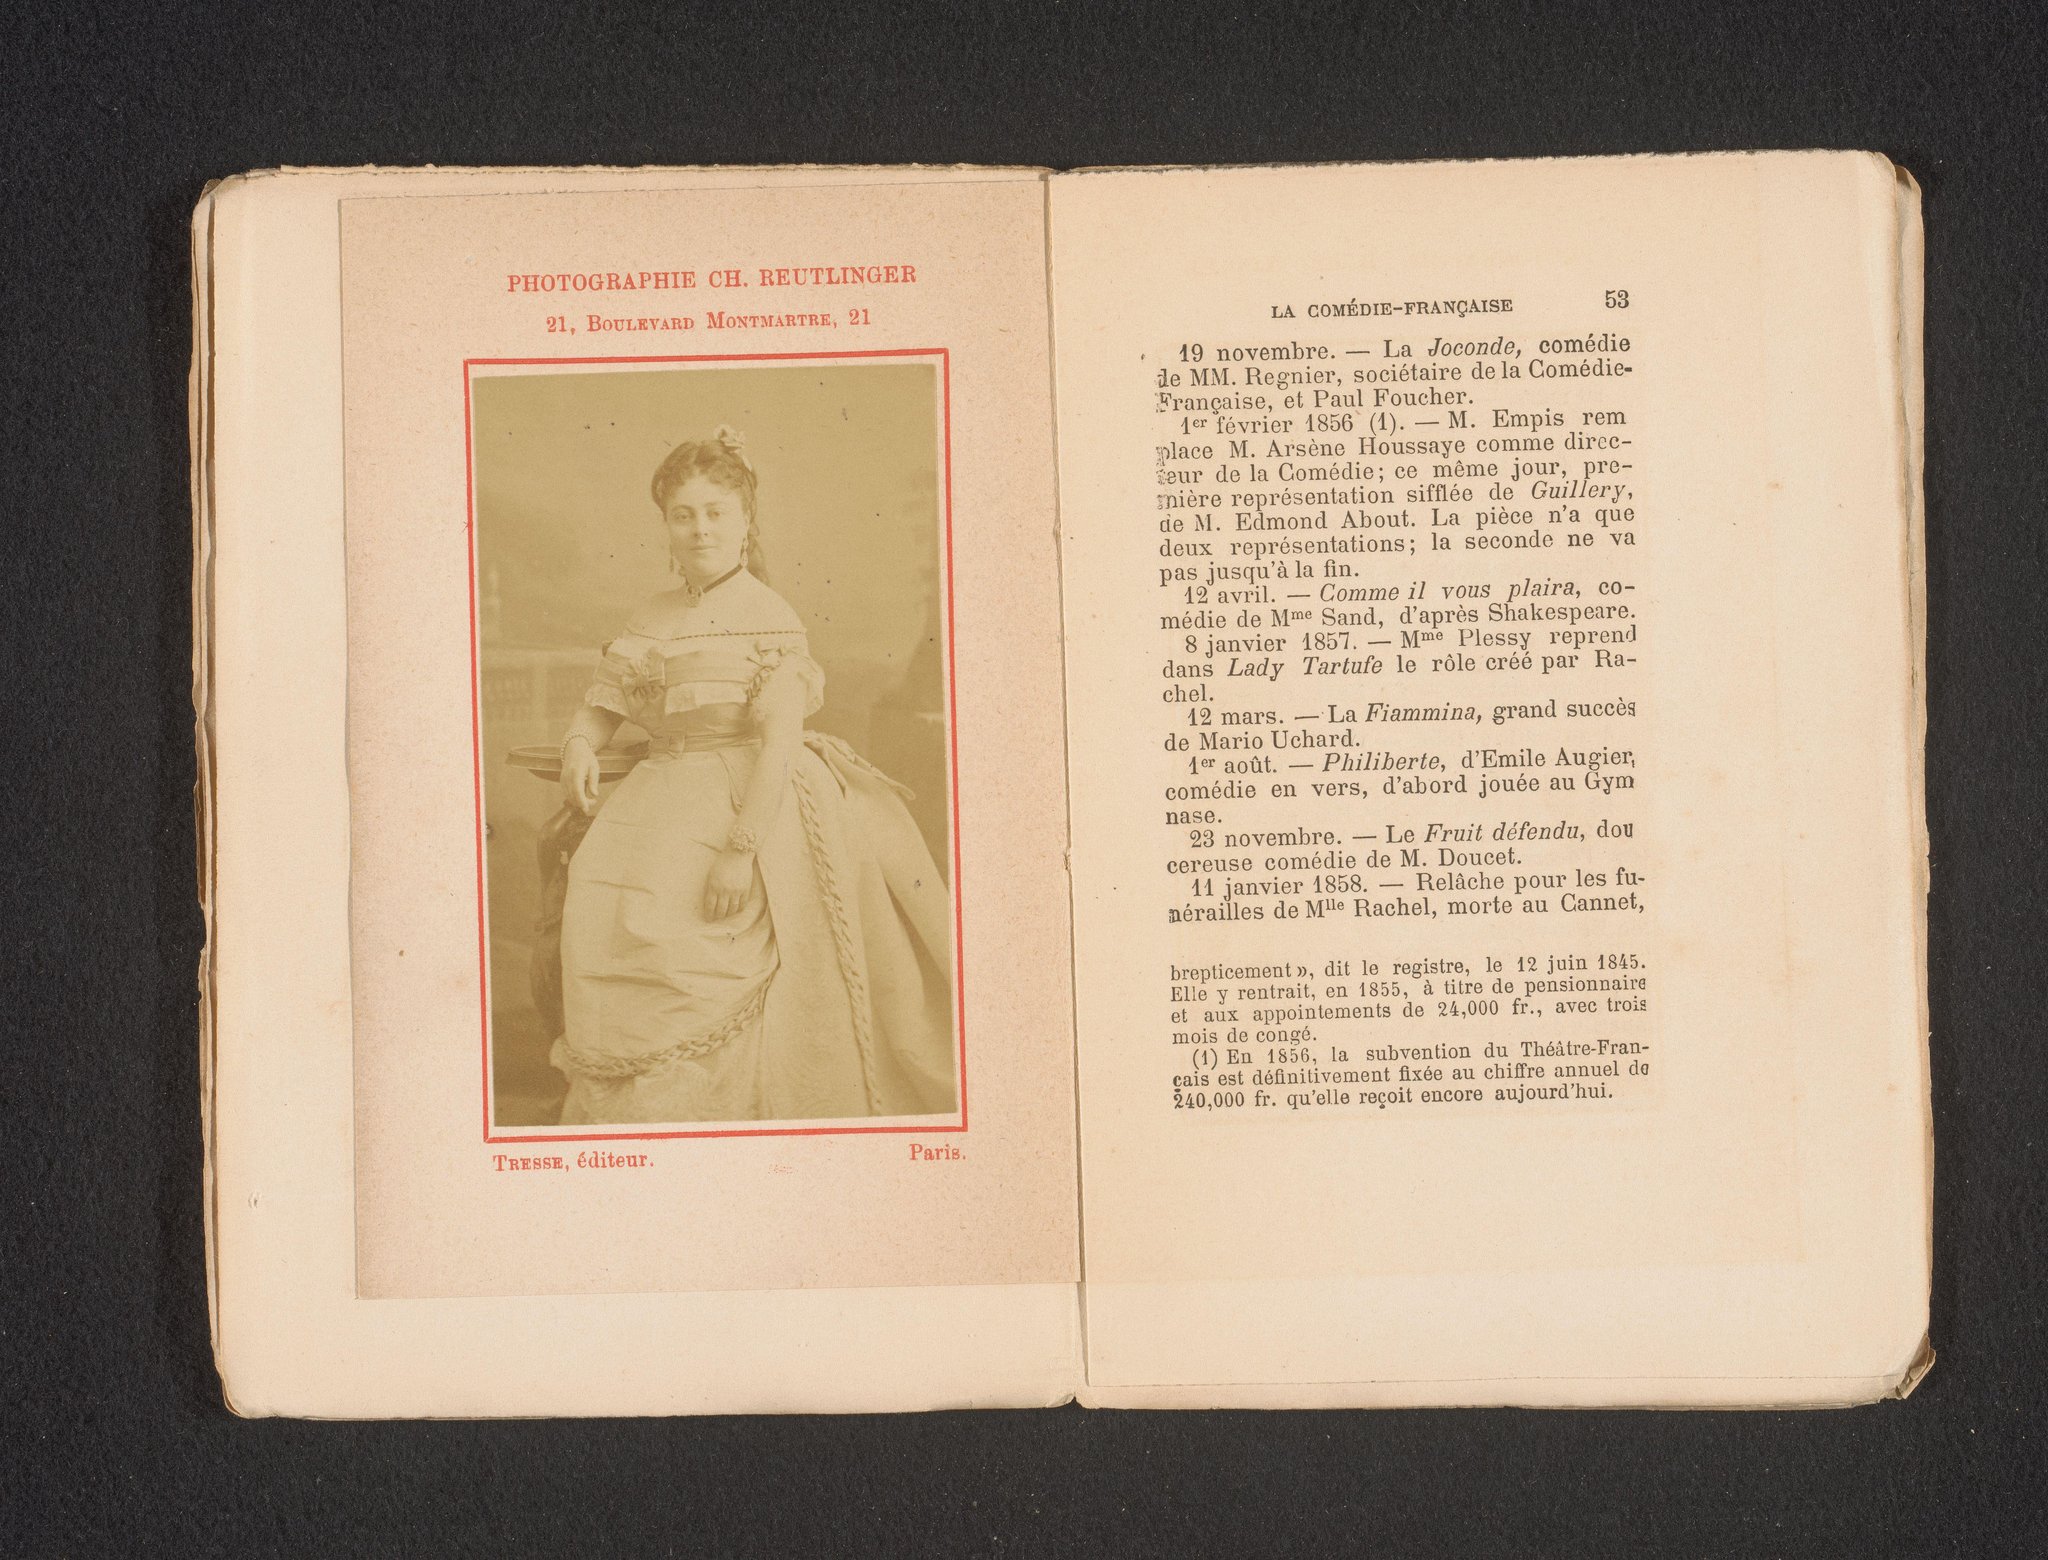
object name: page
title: Portret van een Franse actrice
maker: charles reutlinger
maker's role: publisher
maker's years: 1816-1880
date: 1874-1884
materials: photographic support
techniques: albumen print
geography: paris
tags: portrait of actor, actress